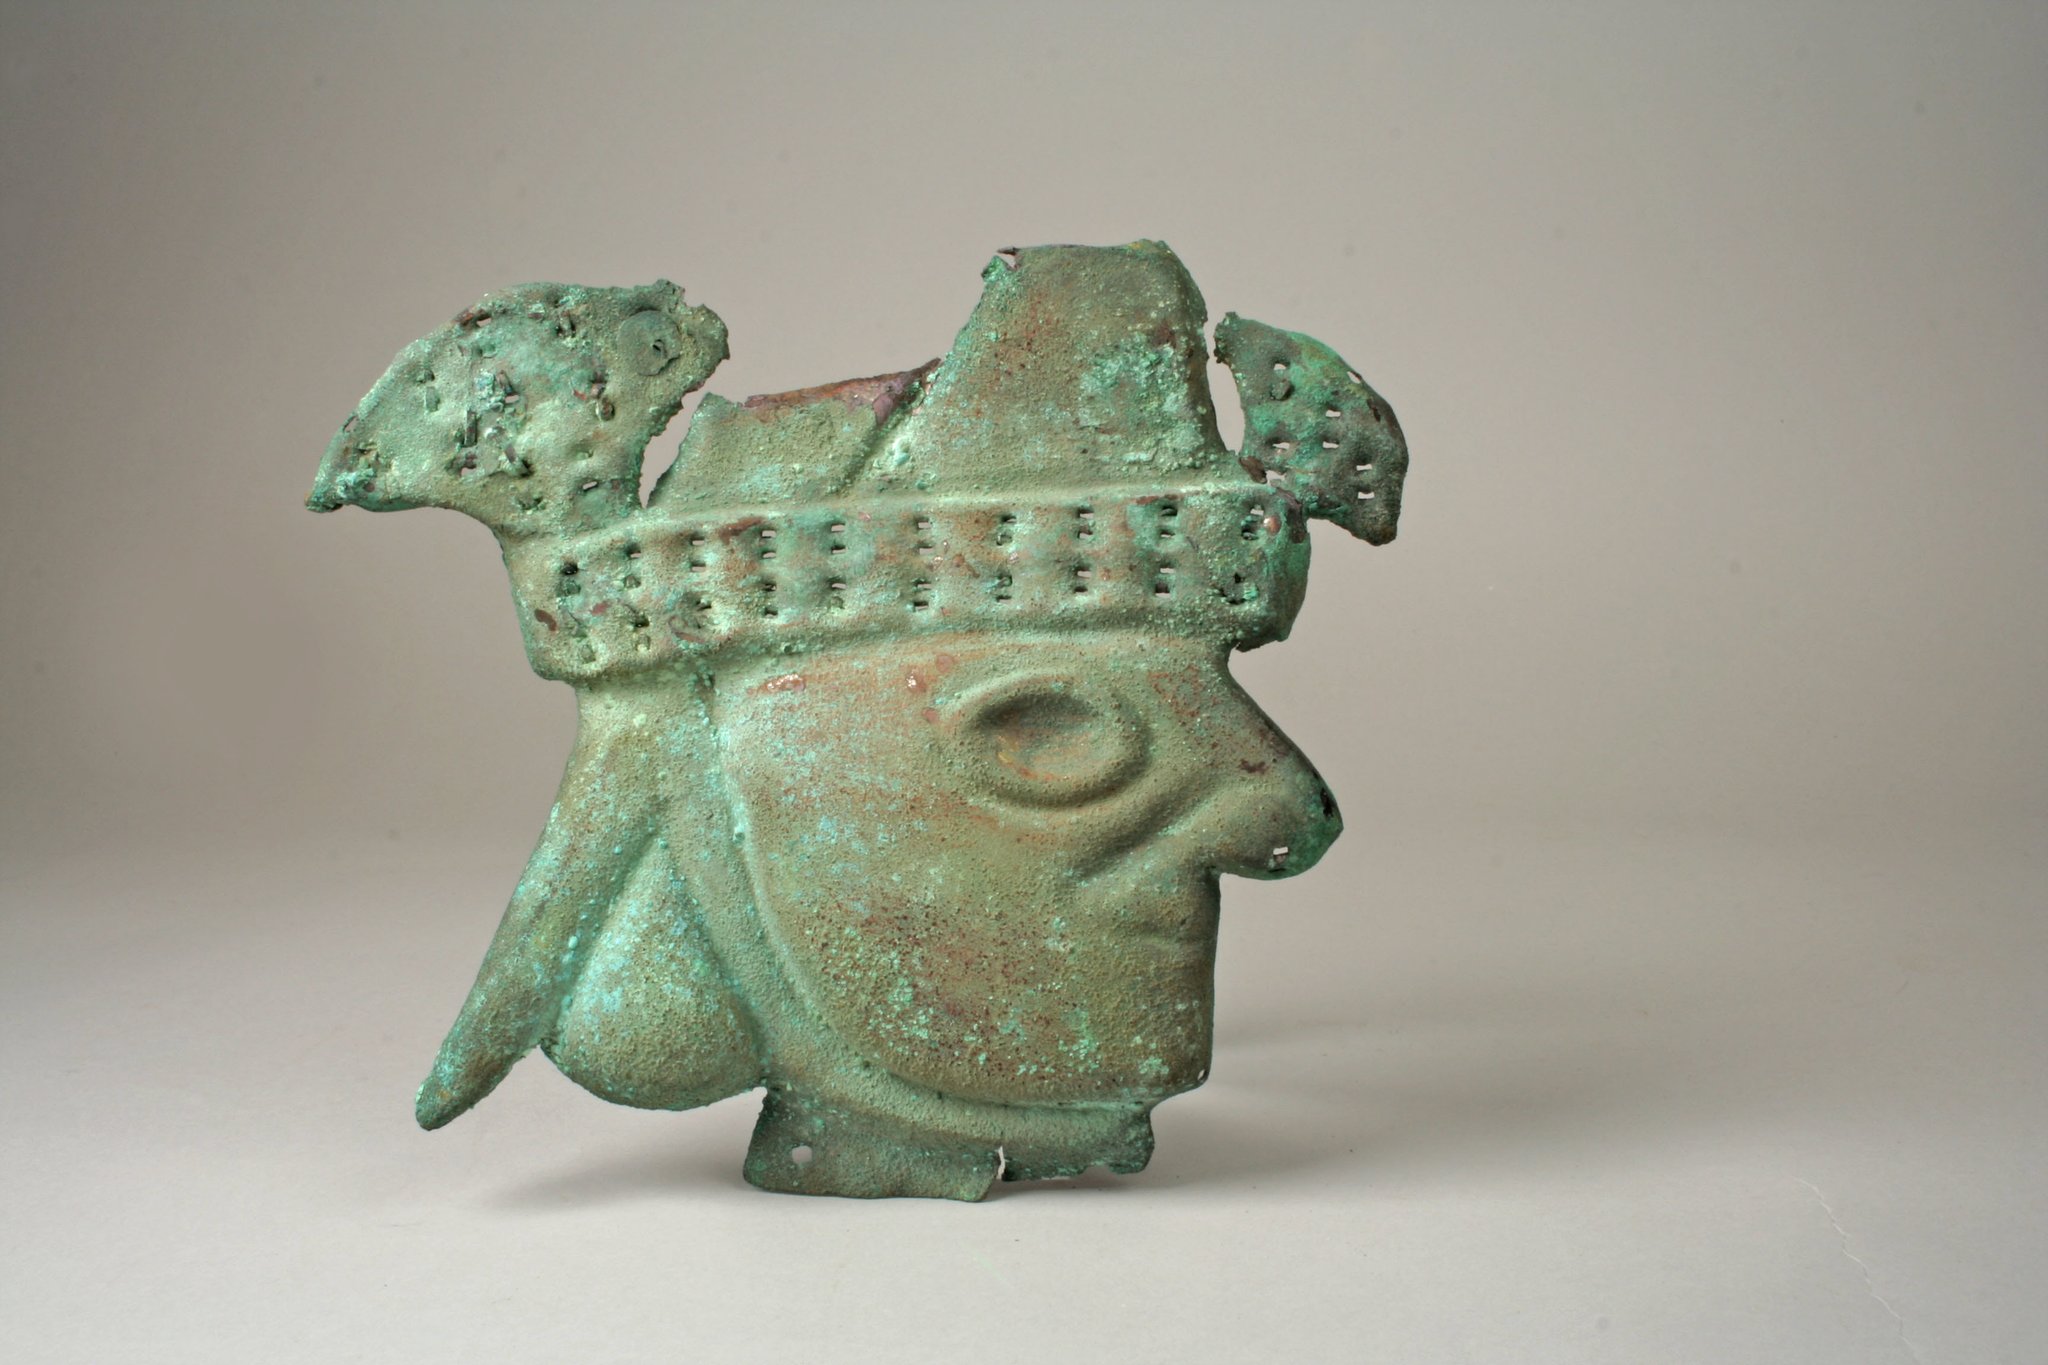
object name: ornament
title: Profile Face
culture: moche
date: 501-700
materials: metal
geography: peru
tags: faces,profiles